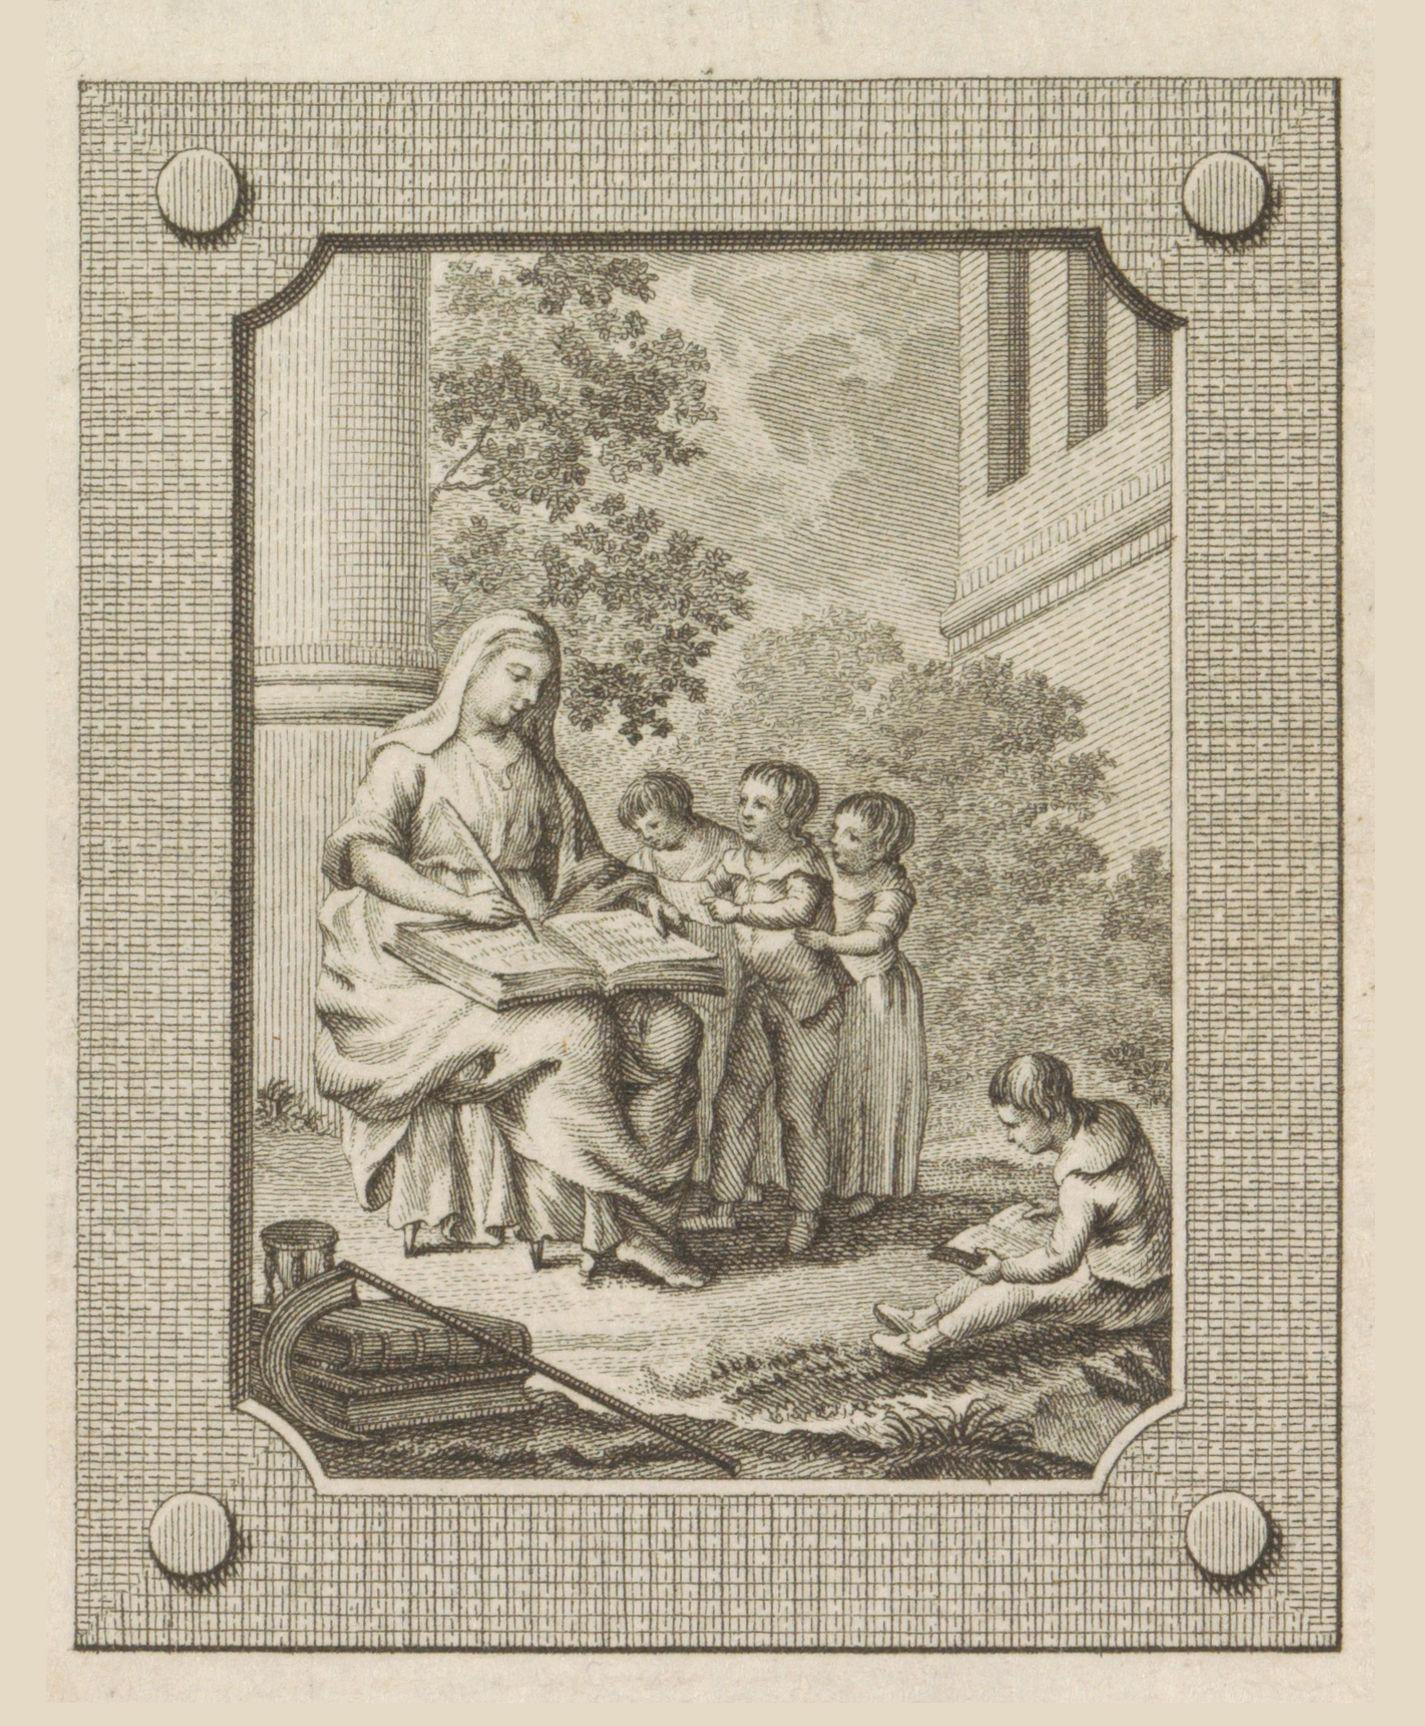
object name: print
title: Titelpagina voor: J. Hazeu, Historie der omwentelingen in vaderlandsche gesprekken voor kinderen, 1796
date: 1794-1796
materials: paper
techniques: engraving, etching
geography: amsterdam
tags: 'historia'; 'historia' (ripa), patriots (1780-1795)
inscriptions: collector's mark: Lugt 2166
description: Titelpagina voor: J. Hazeu, Historie der omwentelingen in vaderlandsche gesprekken voor kinderen, 1796. Titel met embleem van Geschiedenis (Historia) die in een boek schrijft, drie kinderen kijken toe.